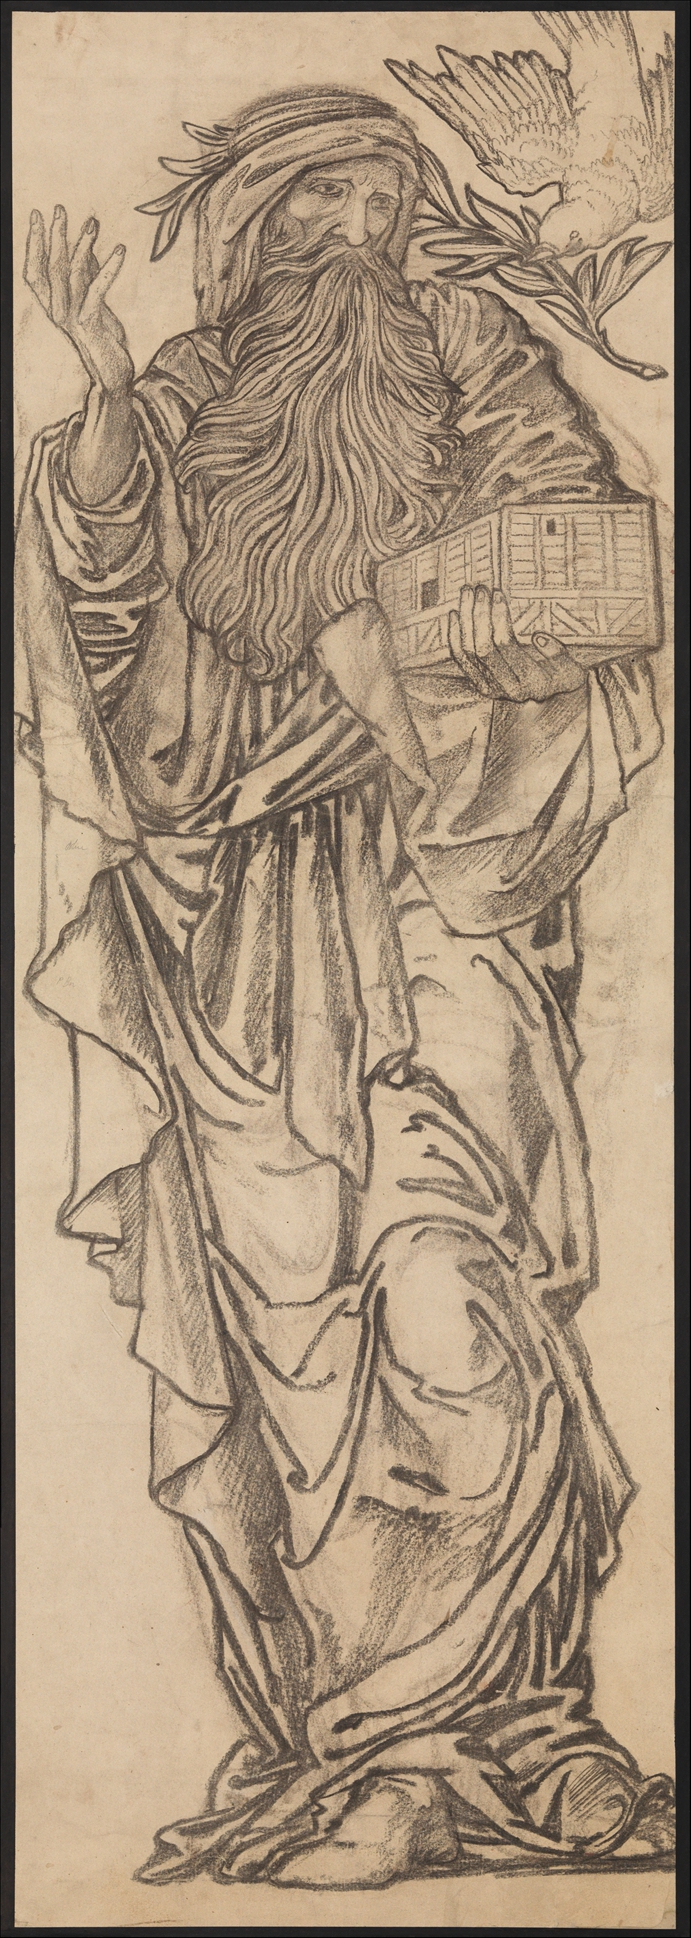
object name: drawing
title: Noah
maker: sir edward burne-jones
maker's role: artist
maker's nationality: british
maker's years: 1833-1898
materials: charcoal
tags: birds,men